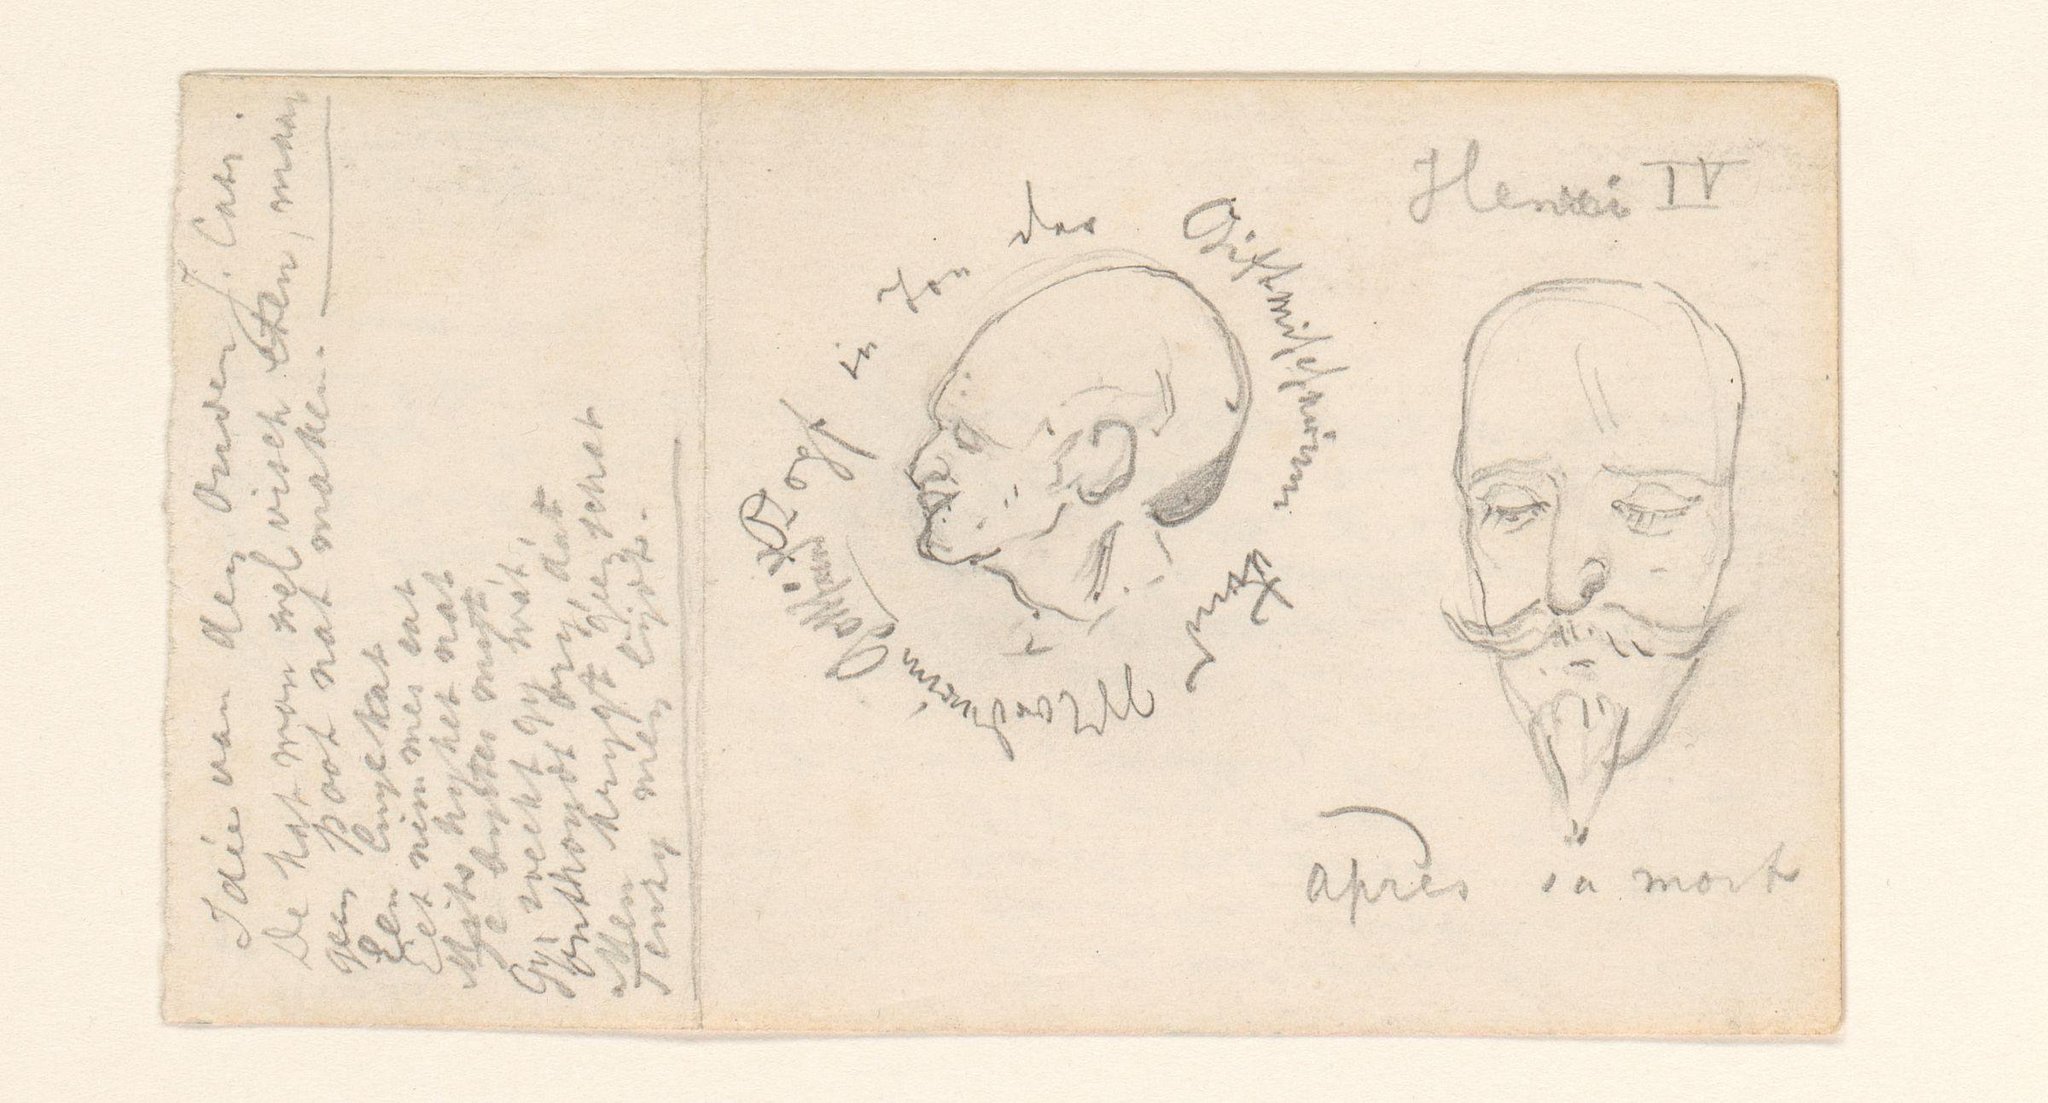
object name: drawing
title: Schetsblad met gedichten en schetsjes van het dodenmasker van Hendrik IV, koning van Frankrijk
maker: august allebé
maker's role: draughtsman, print maker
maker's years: 1838-1927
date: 1848-1927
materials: paper, pencil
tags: hendrik iv (koning van frankrijk en navarra), death-mask, historical persons